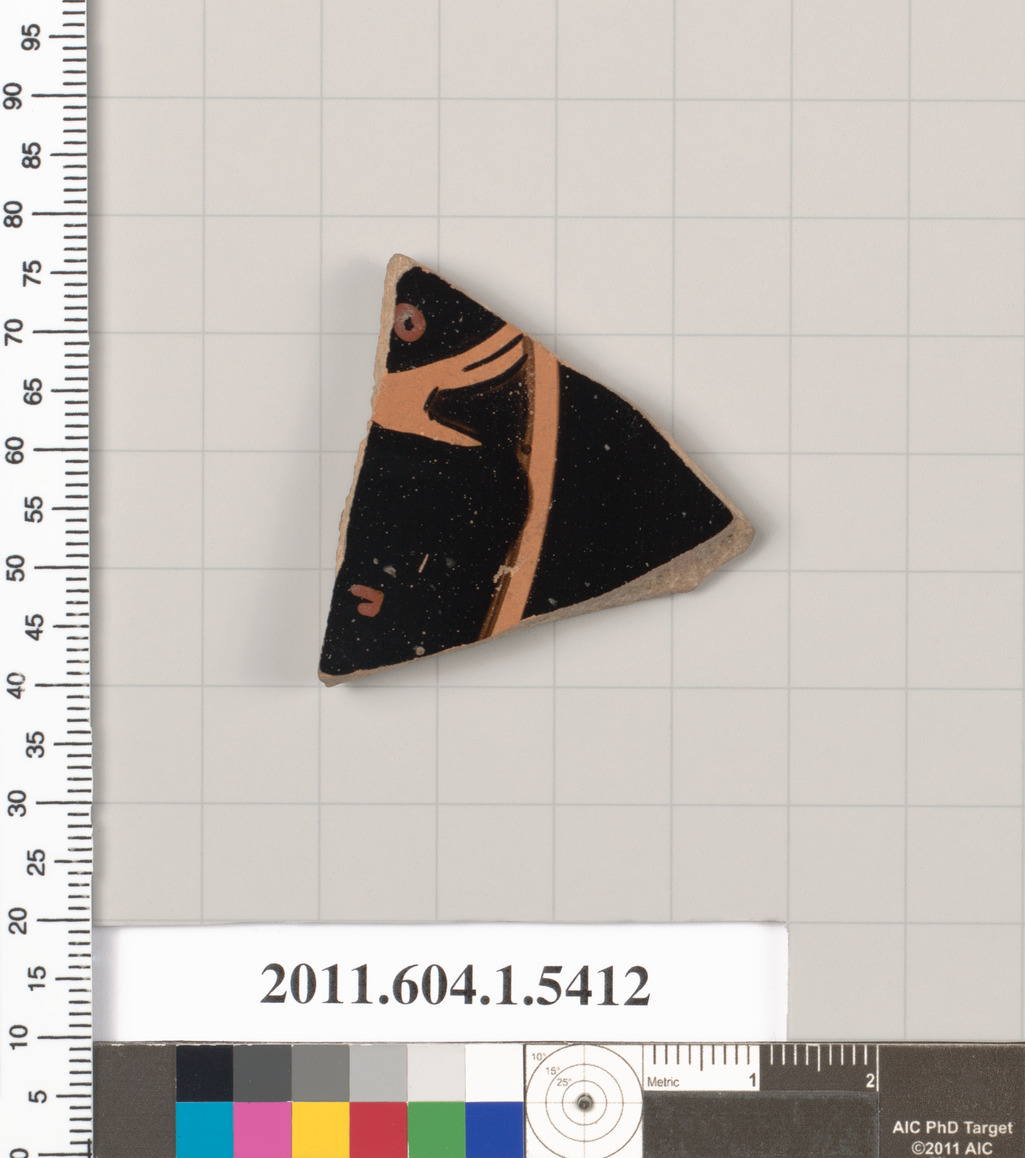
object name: kylix fragment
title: Terracotta fragment of a kylix (drinking cup)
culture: greek, attic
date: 520-500 BCE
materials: terracotta